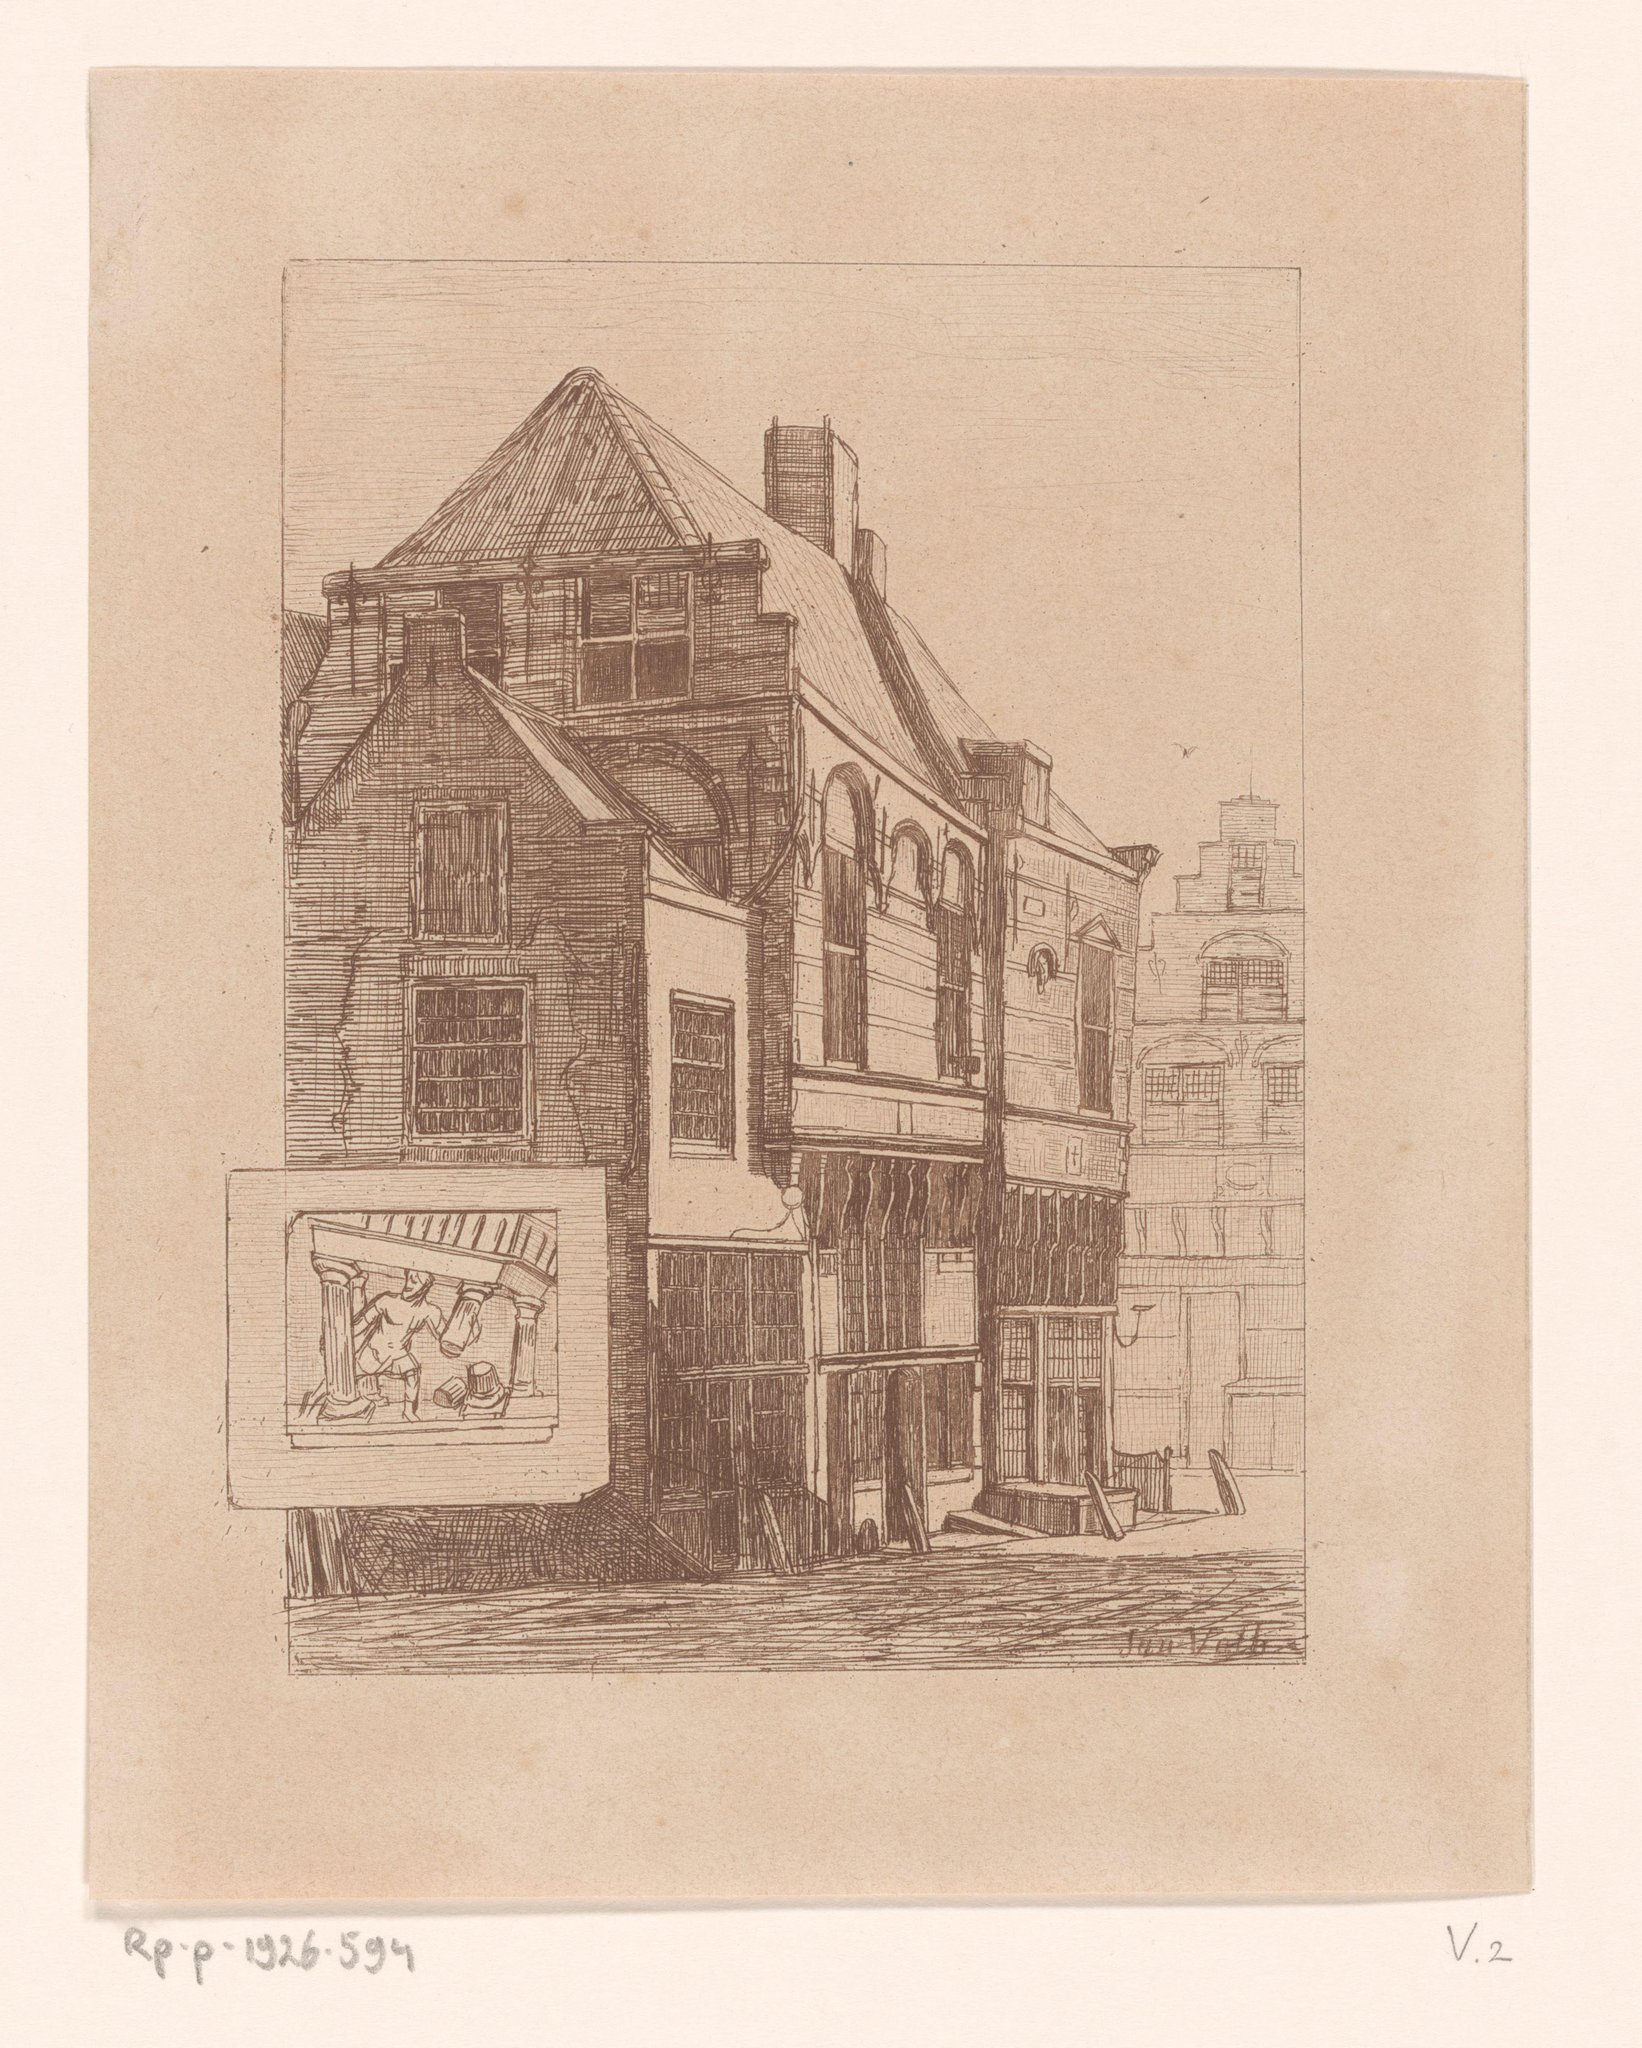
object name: print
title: Het huis Samson, te Dordrecht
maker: jan veth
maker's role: designer, draughtsman, painter, print maker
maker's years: 1864-1925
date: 1885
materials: paper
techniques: etching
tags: urban housing, dordrecht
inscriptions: collector's mark: Lugt 2228